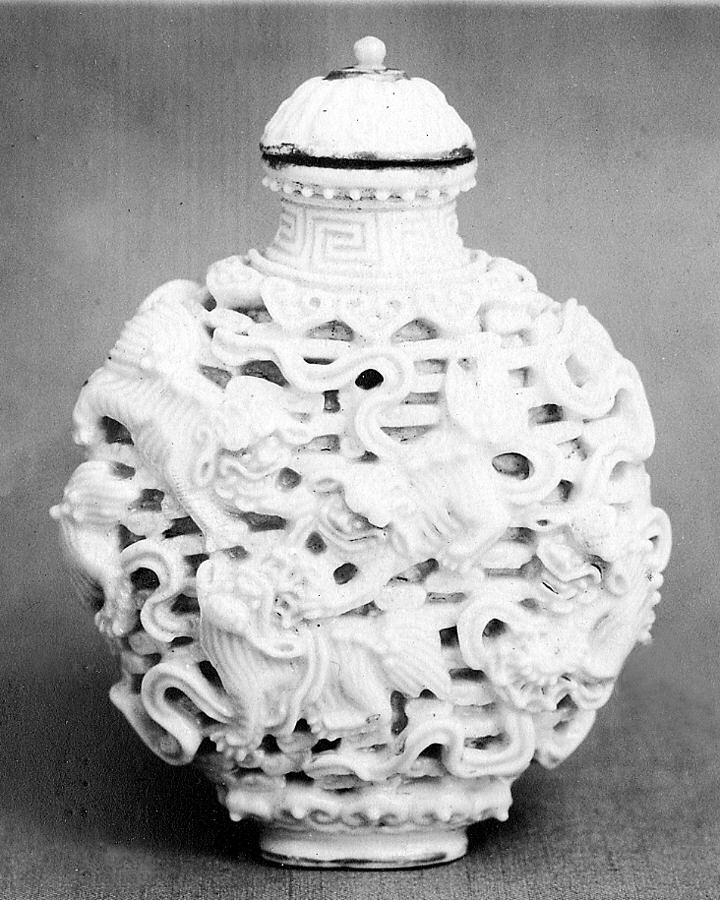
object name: snuff bottle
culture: chinese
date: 1796-1820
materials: porcelain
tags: animals